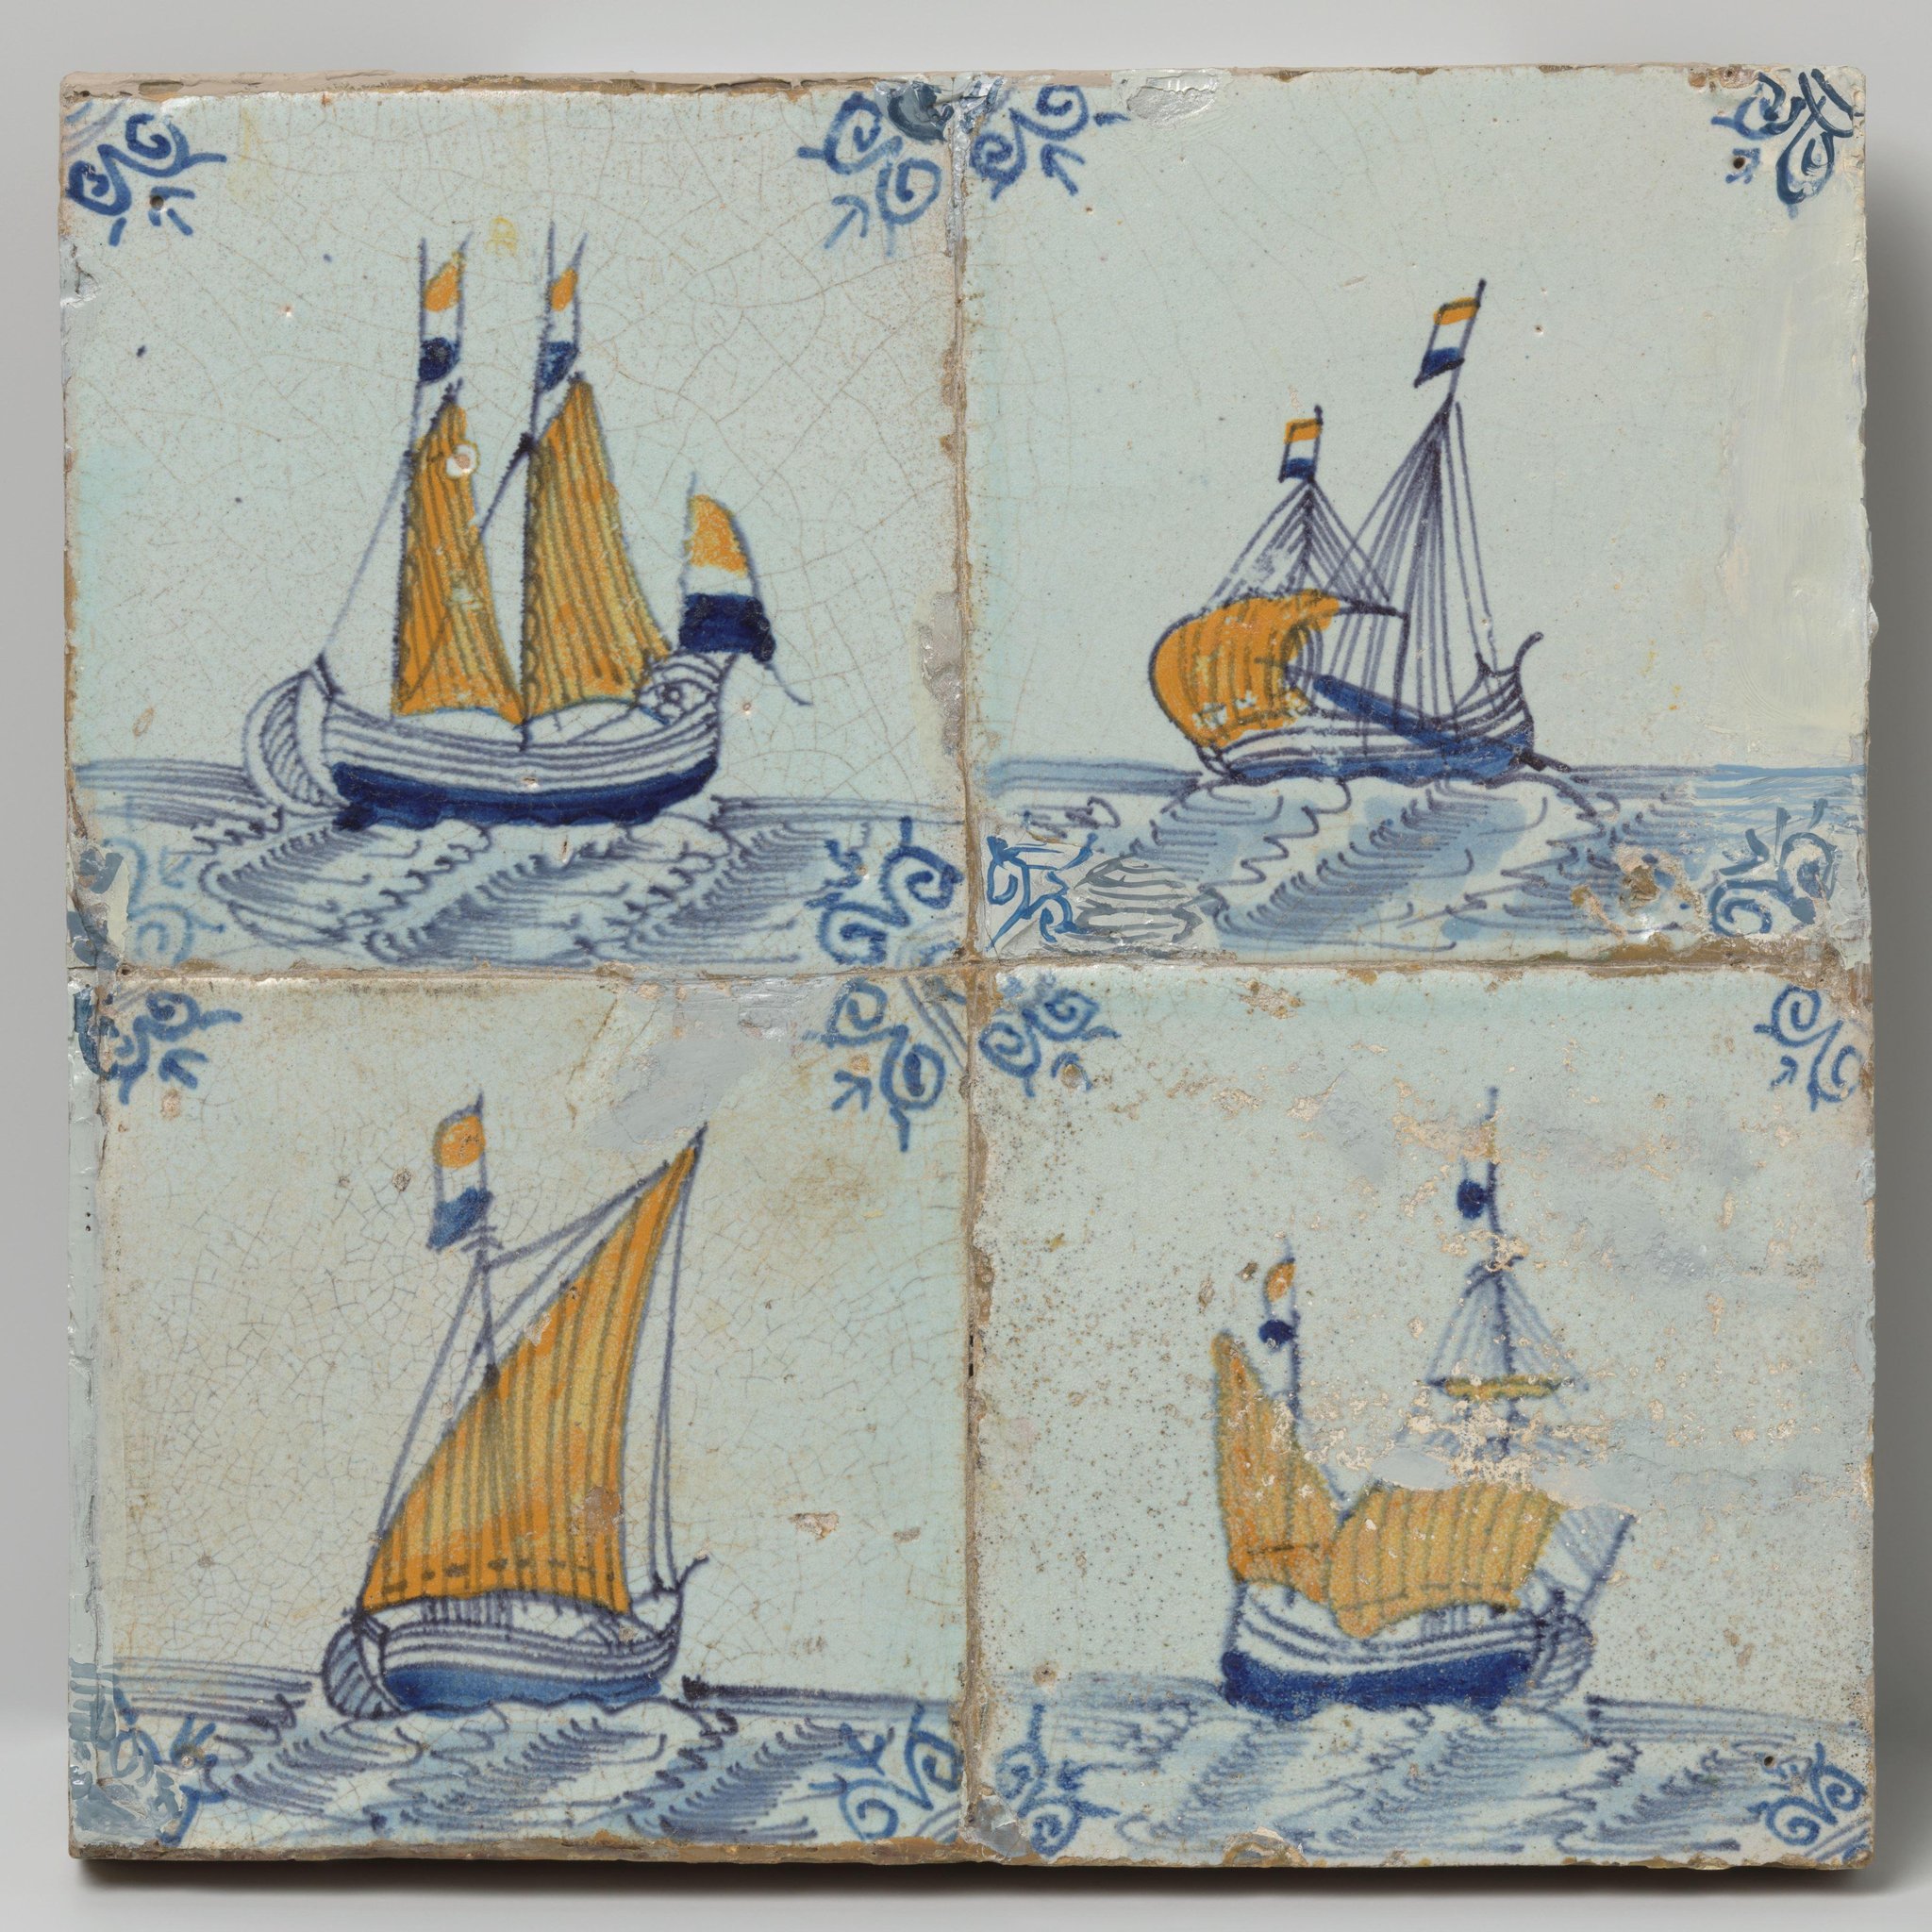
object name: tile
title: Veld van vier tegels met schepen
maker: Anonymous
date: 1650-1680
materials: earthenware, glaze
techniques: maiolica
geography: netherlands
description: Veld van vier tegels (2 x 2) elk met een blauw en paars geschilderd schip. In de hoeken, een ossenkop.